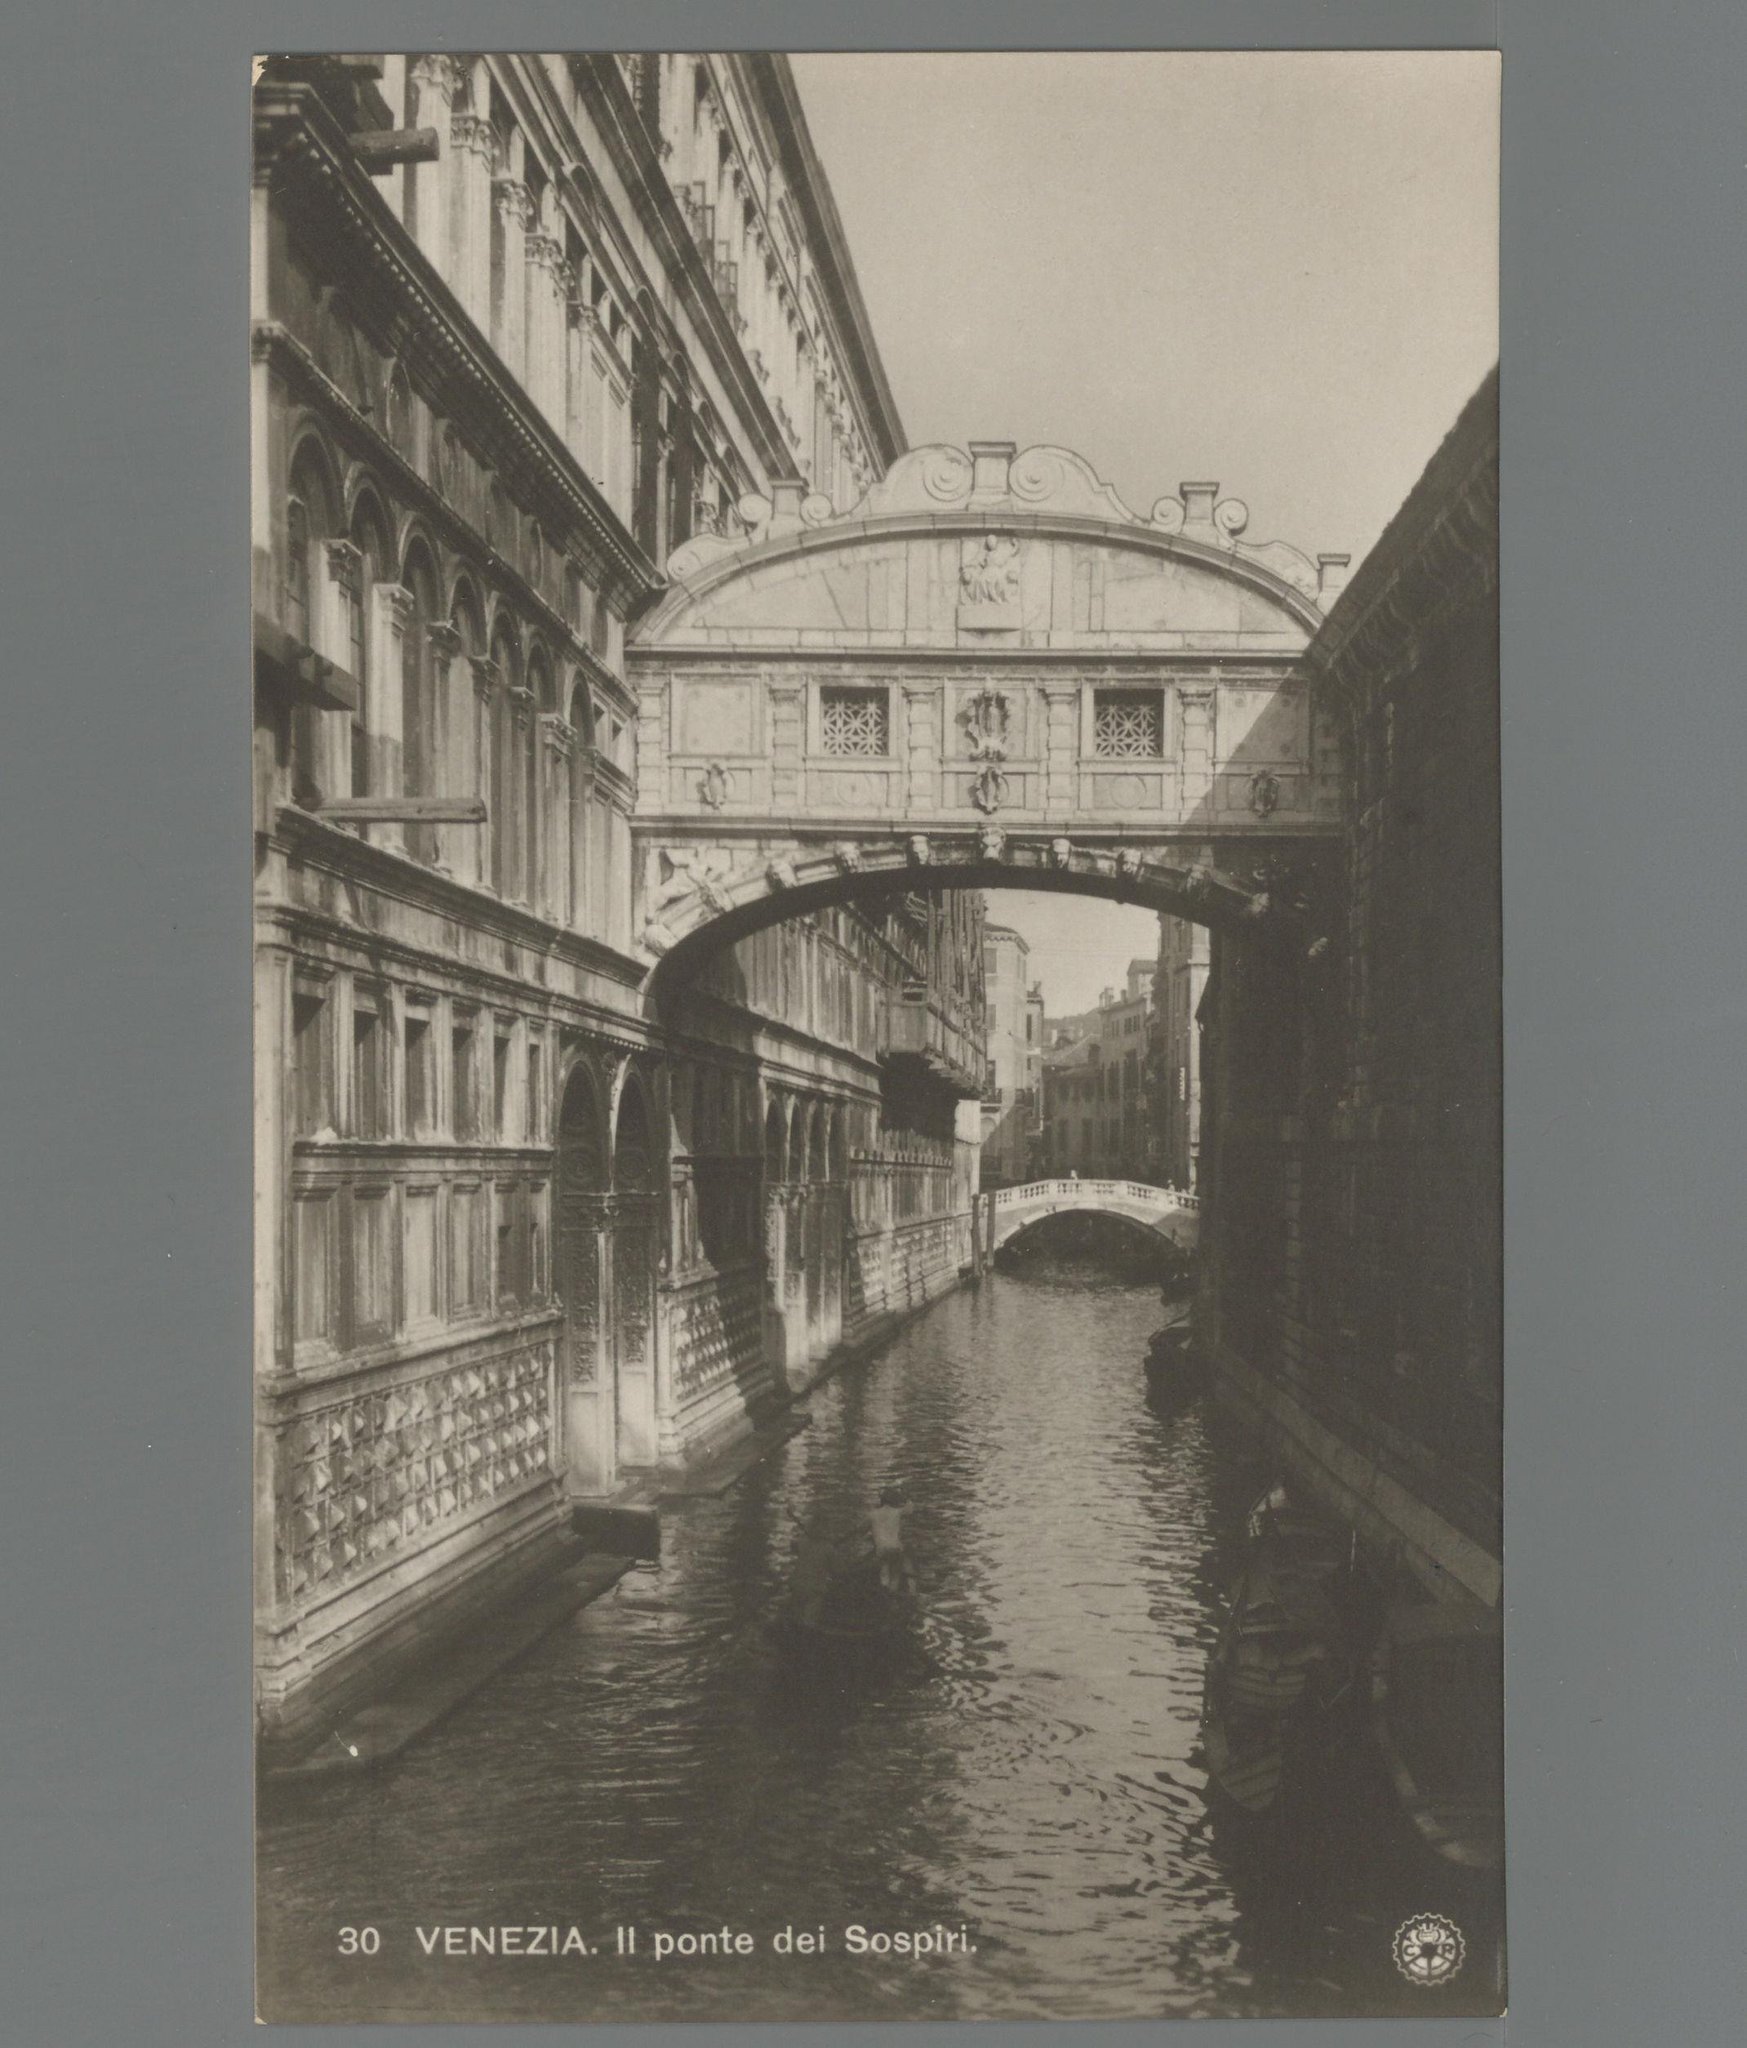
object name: photograph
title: Venezia. Il ponte dei Sospiri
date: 1906-1920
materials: photographic support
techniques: photography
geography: milan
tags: bridge in city across river, canal, etc. (+ city(-scape) with figures, staffage), canal